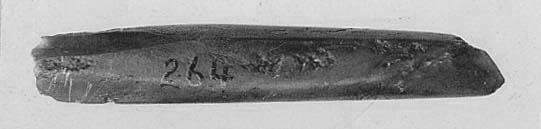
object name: knife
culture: north american, alaskan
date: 1902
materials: jade